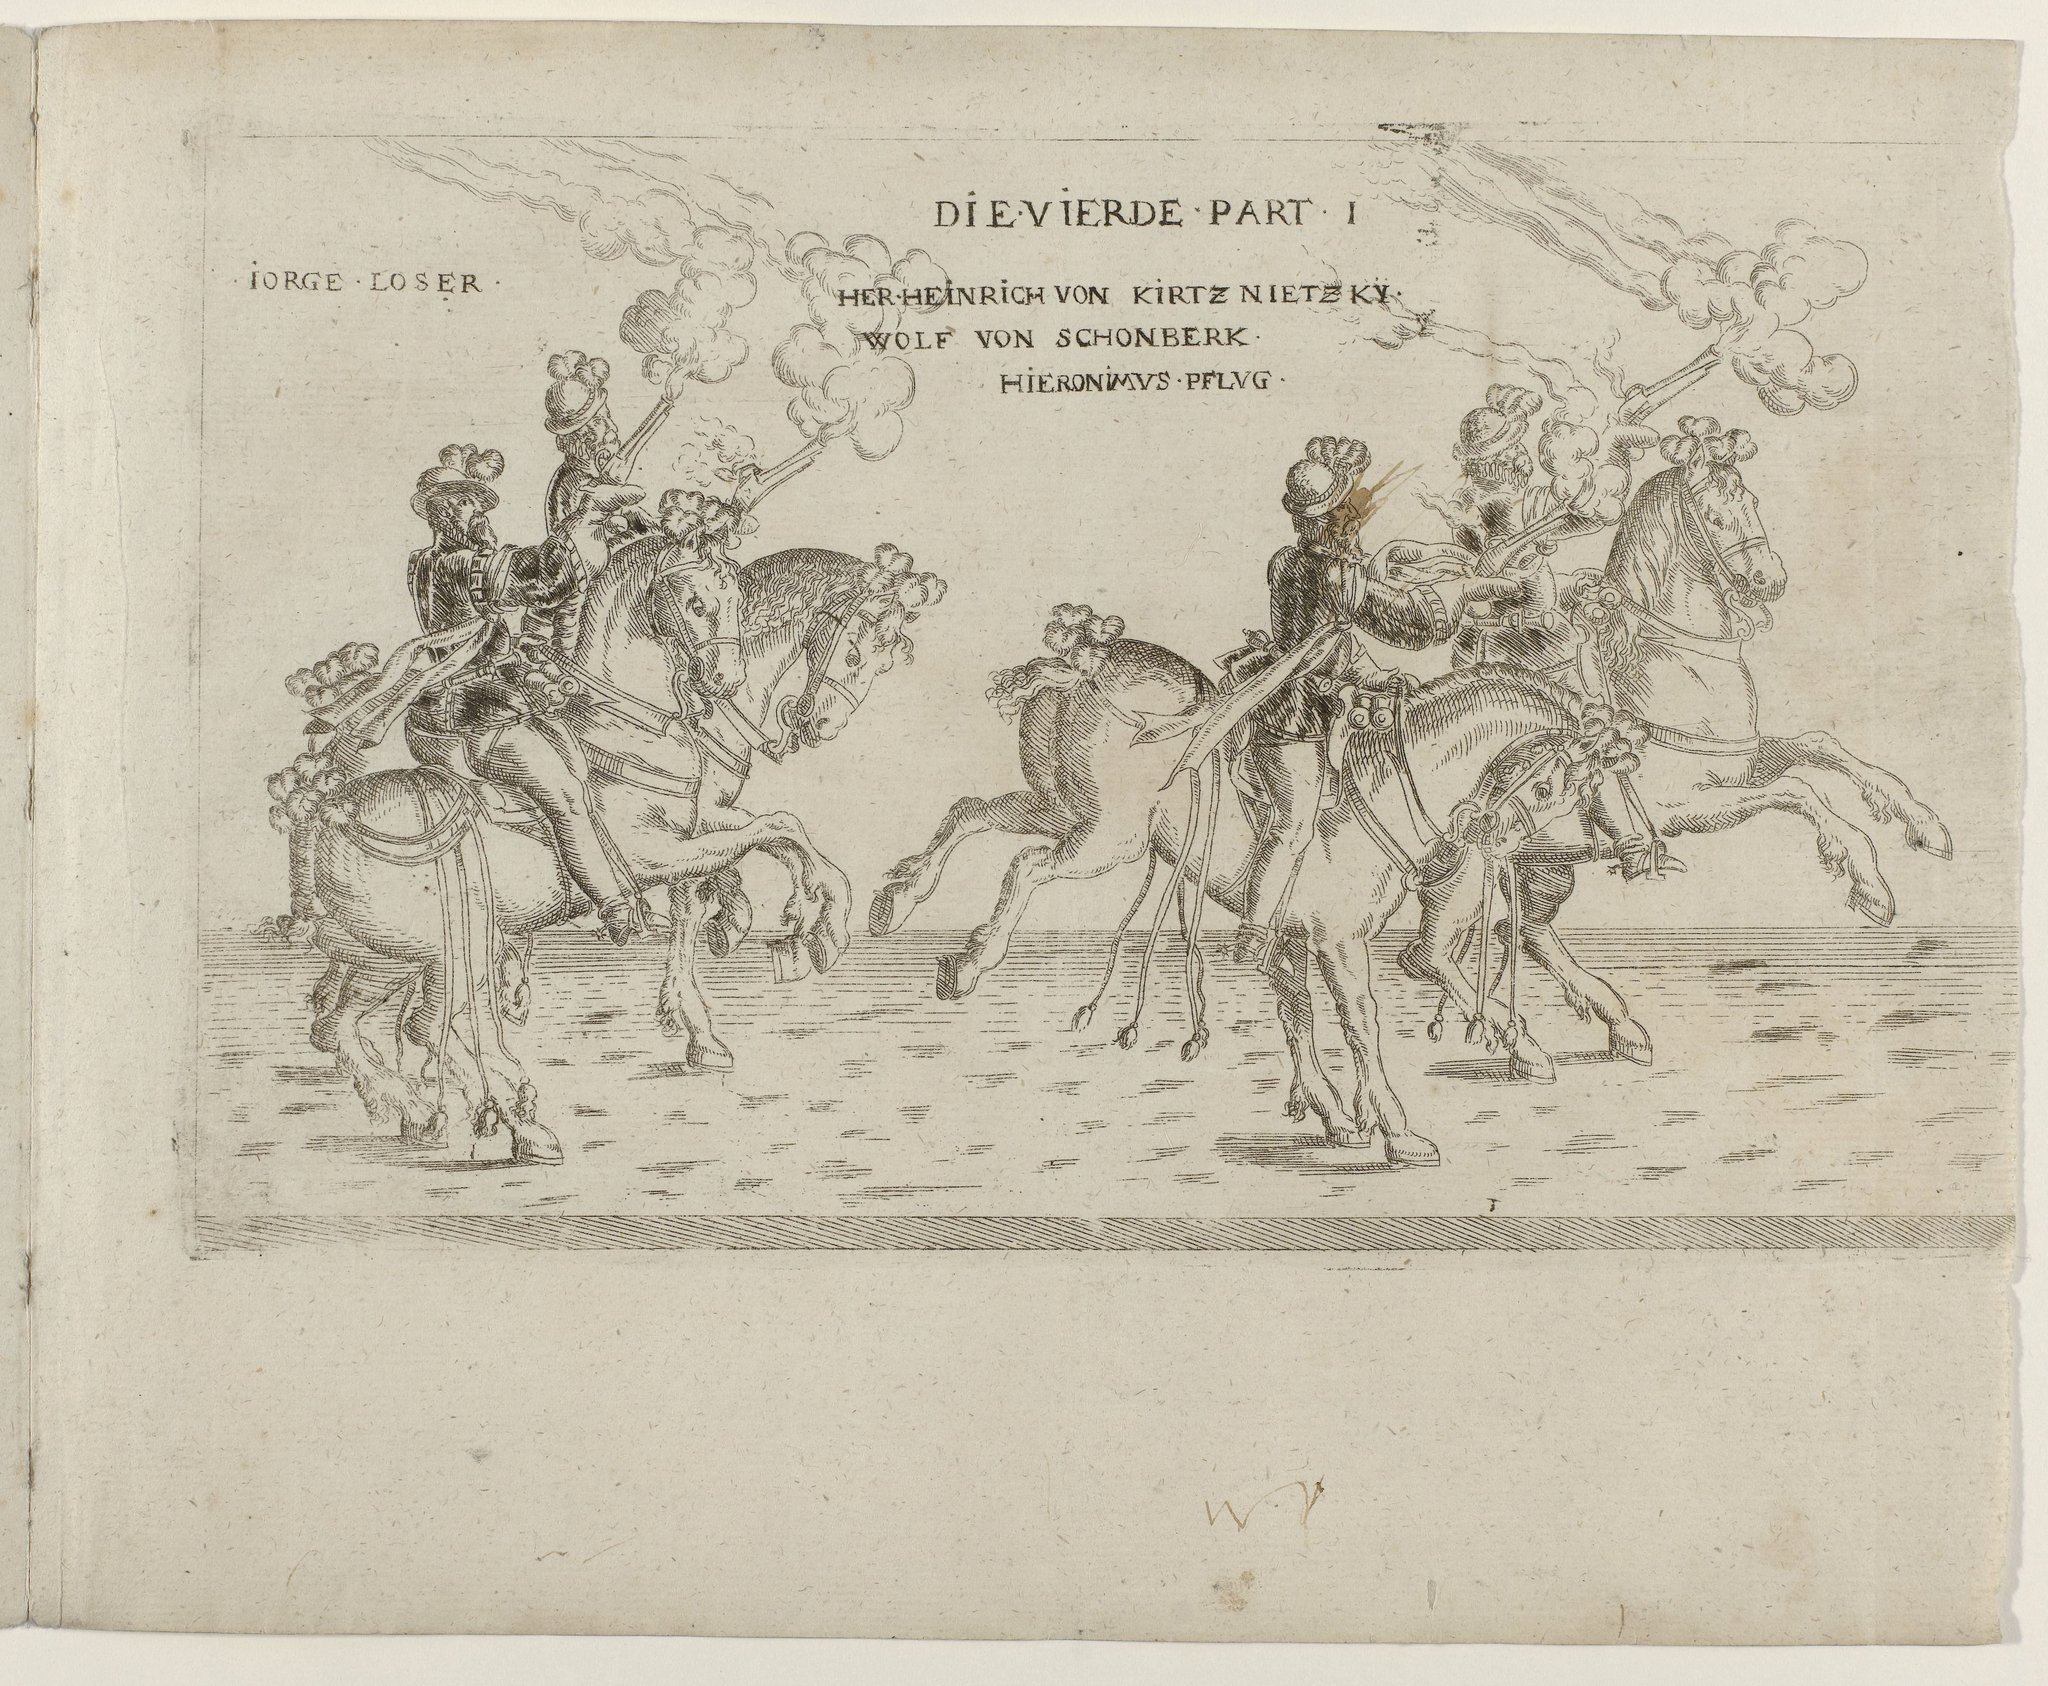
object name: print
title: Ruiters Jorge Loser, Her Heinrich von Kirtznietzky, Wolf von Schonberk en Hieronimus Pflug vuren pistolen af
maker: Anonymous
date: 1553-1586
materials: paper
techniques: etching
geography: germany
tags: riding a horse, ass, or mule; rider, horseman, dress-up party, rejoicing on special occasions (+ parade, pageant, cavalcade ~ festive activities), firearms (with name)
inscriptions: collector's mark: Lugt 2228, collector's mark: Lugt 2760